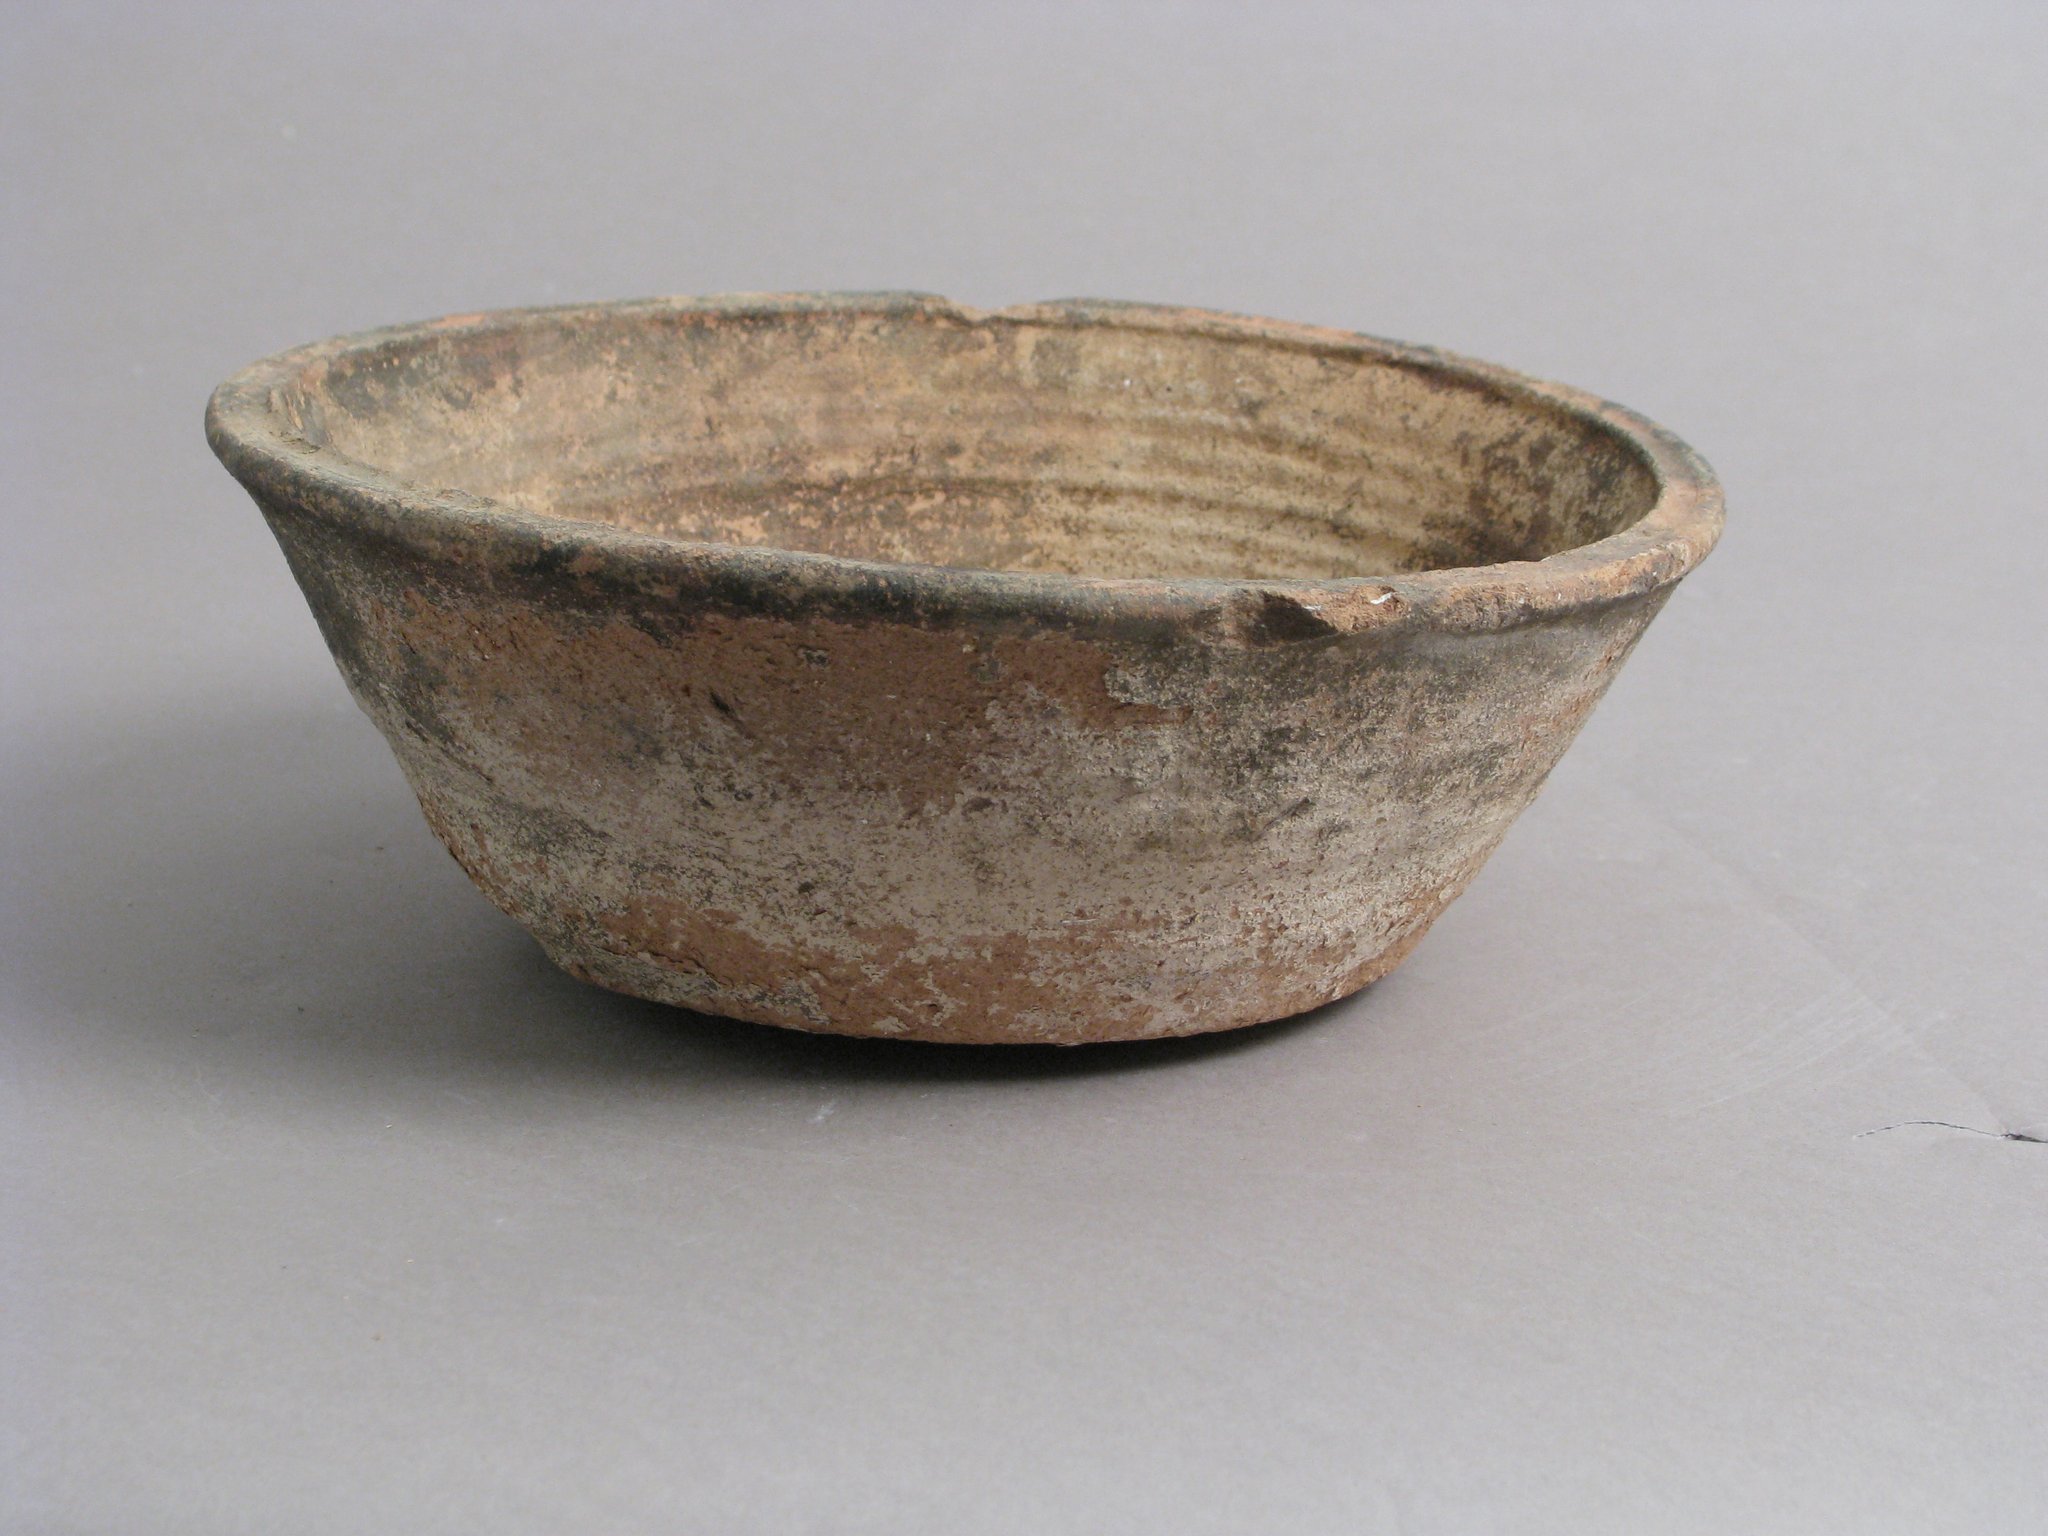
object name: bowl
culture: coptic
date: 301-700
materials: earthenware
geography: egypt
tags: bowls